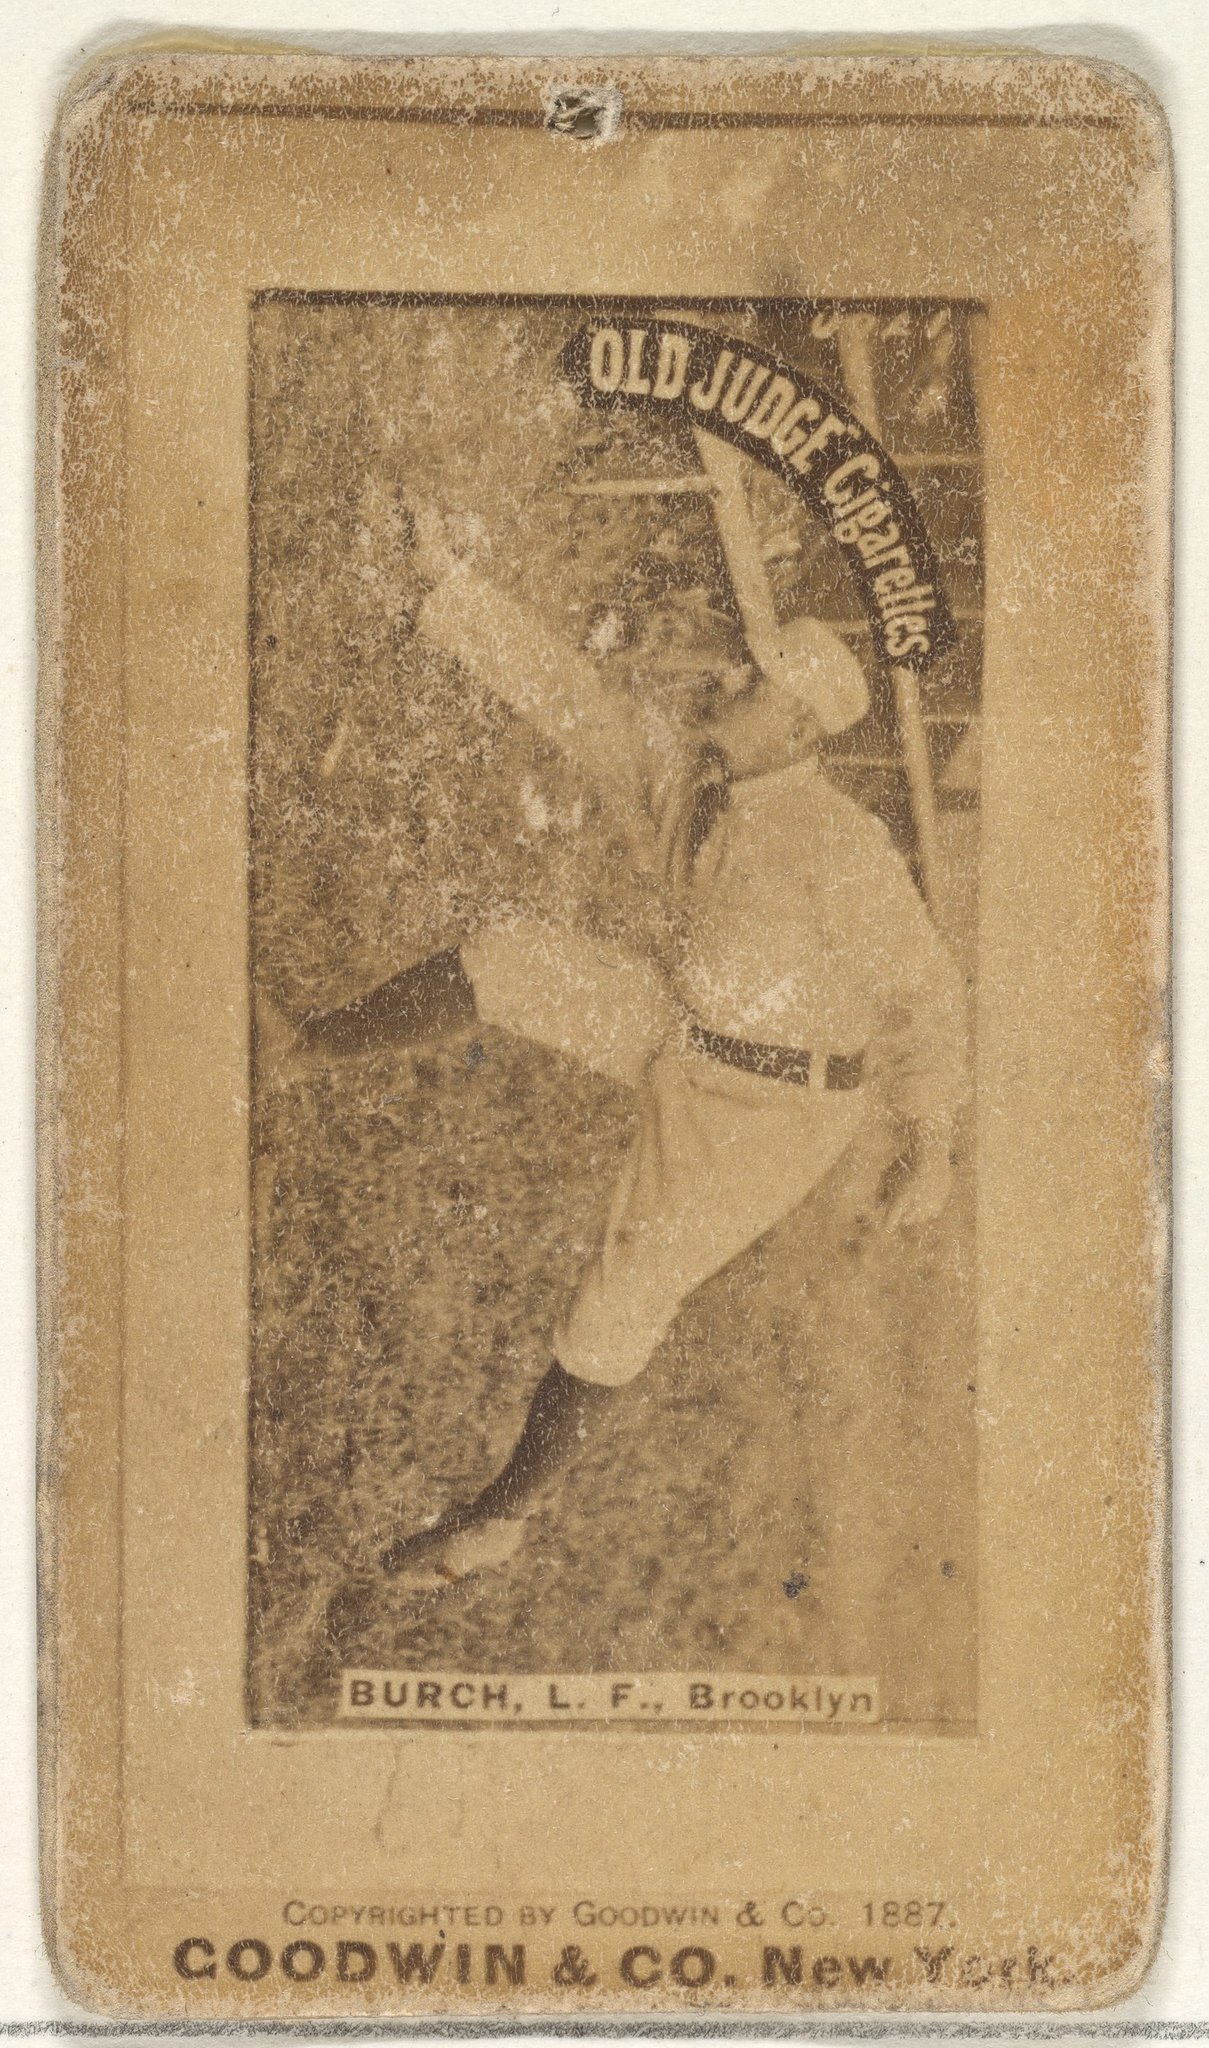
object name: baseball card, photograph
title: Burch, Left Field, Brooklyn, from the Old Judge series (N172) for Old Judge Cigarettes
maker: goodwin & company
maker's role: publisher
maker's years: 1850-1950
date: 1887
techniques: albumen silver print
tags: men,portraits,baseball,athletes